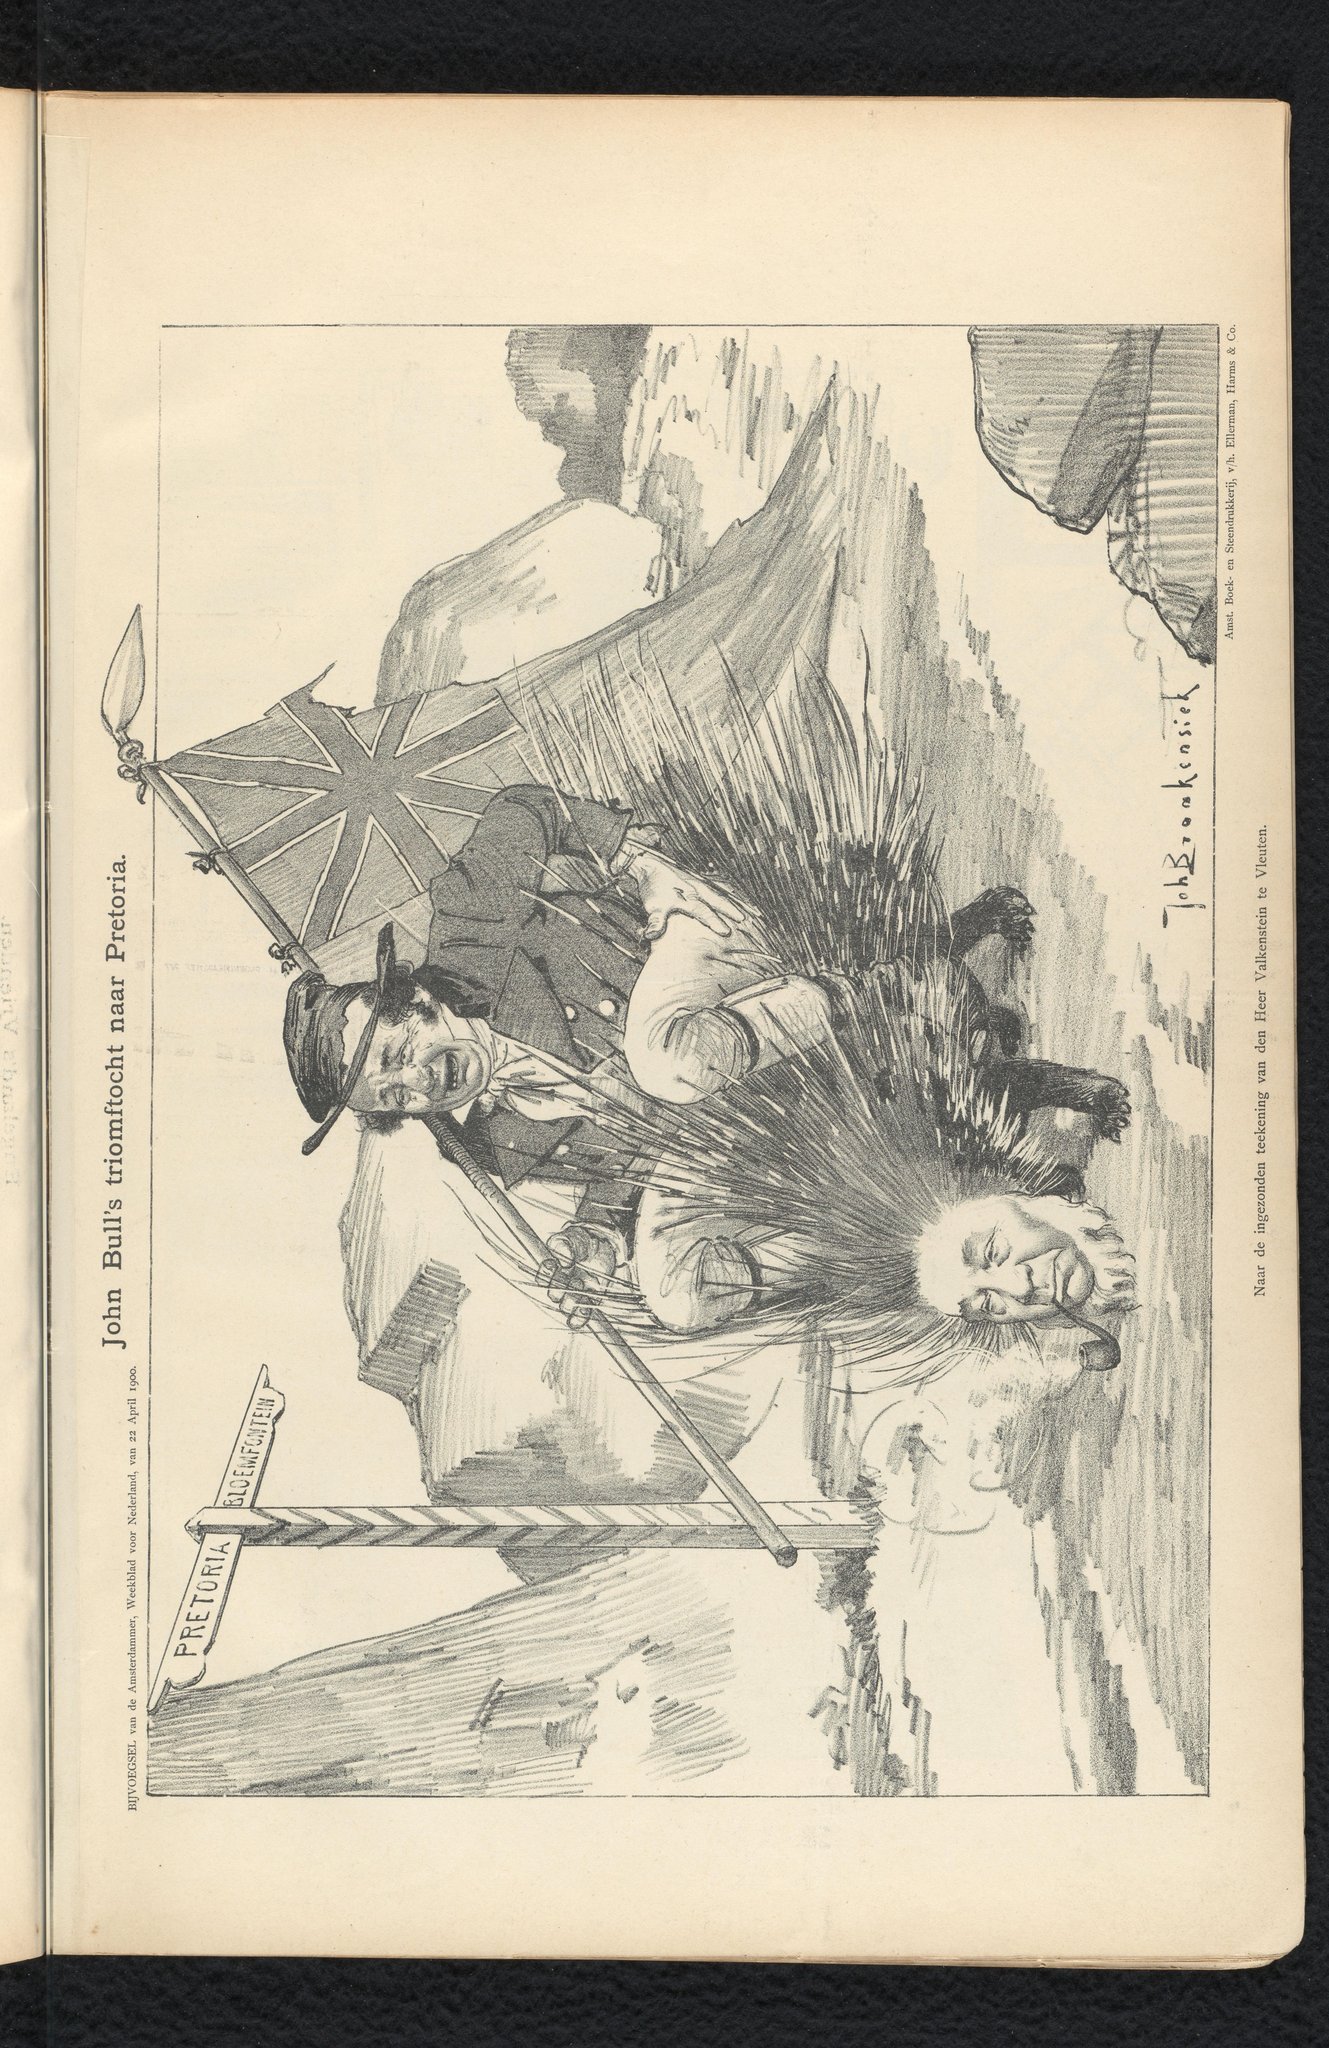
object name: cartoon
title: John Bull's triomftocht naar Pretoria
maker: johan braakensiek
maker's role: draughtsman, print maker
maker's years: 1858-1940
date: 1900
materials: paper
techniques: lithograph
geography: netherlands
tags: personifications of countries, nations, states, districts, etc., other mammals: porcupine, riding on animal other than horse, ass, or mule, political caricatures and satires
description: John Bull (Engeland) onderneemt de pijnlijke 'triomftocht' van Bloemfontein naar Pretoria zittend op het stekelvarken Paul Kruger.